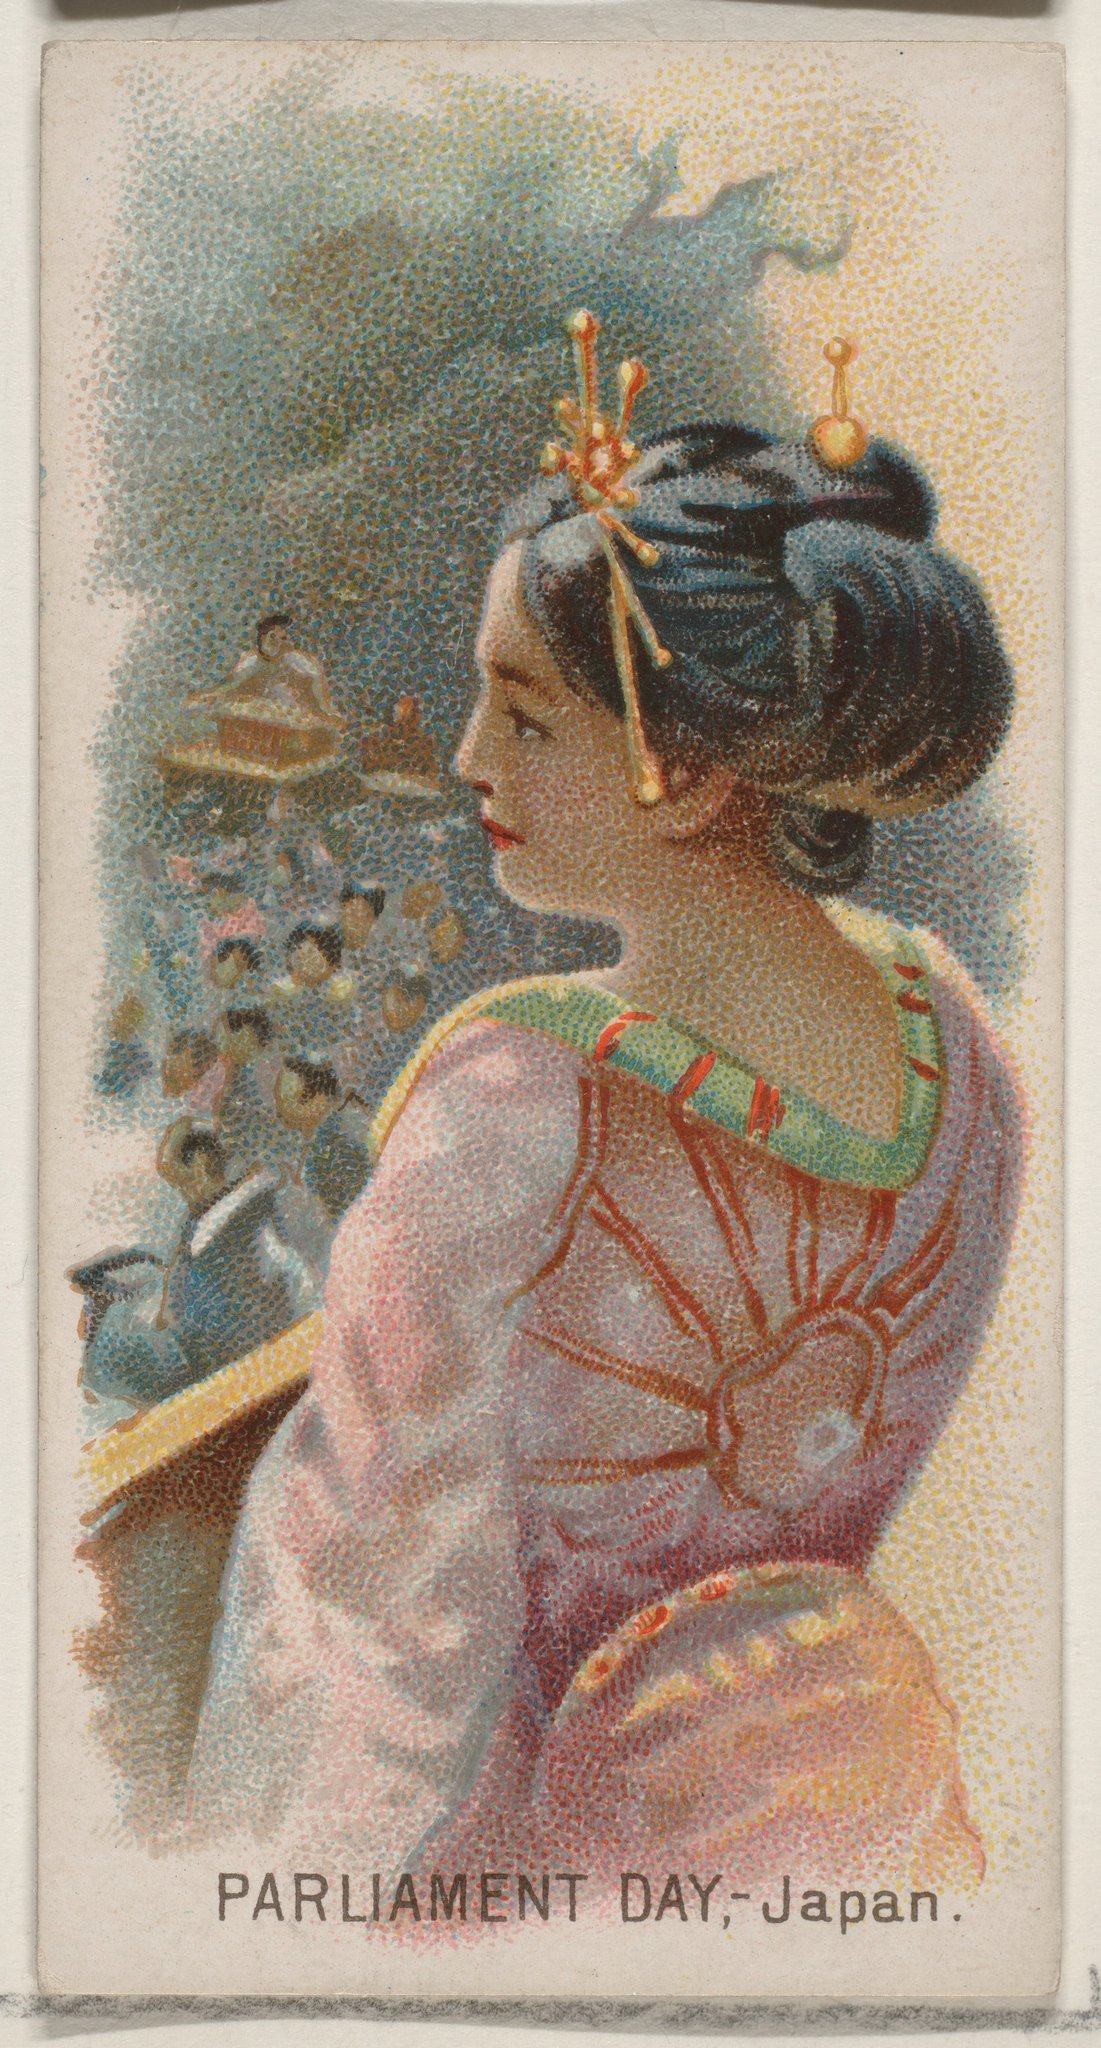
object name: print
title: Parliament Day, Japan, from the Holidays series (N80) for Duke brand cigarettes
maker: w. duke, sons & co.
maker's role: publisher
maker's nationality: american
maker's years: 1870-1920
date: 1890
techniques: color lithograph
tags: women